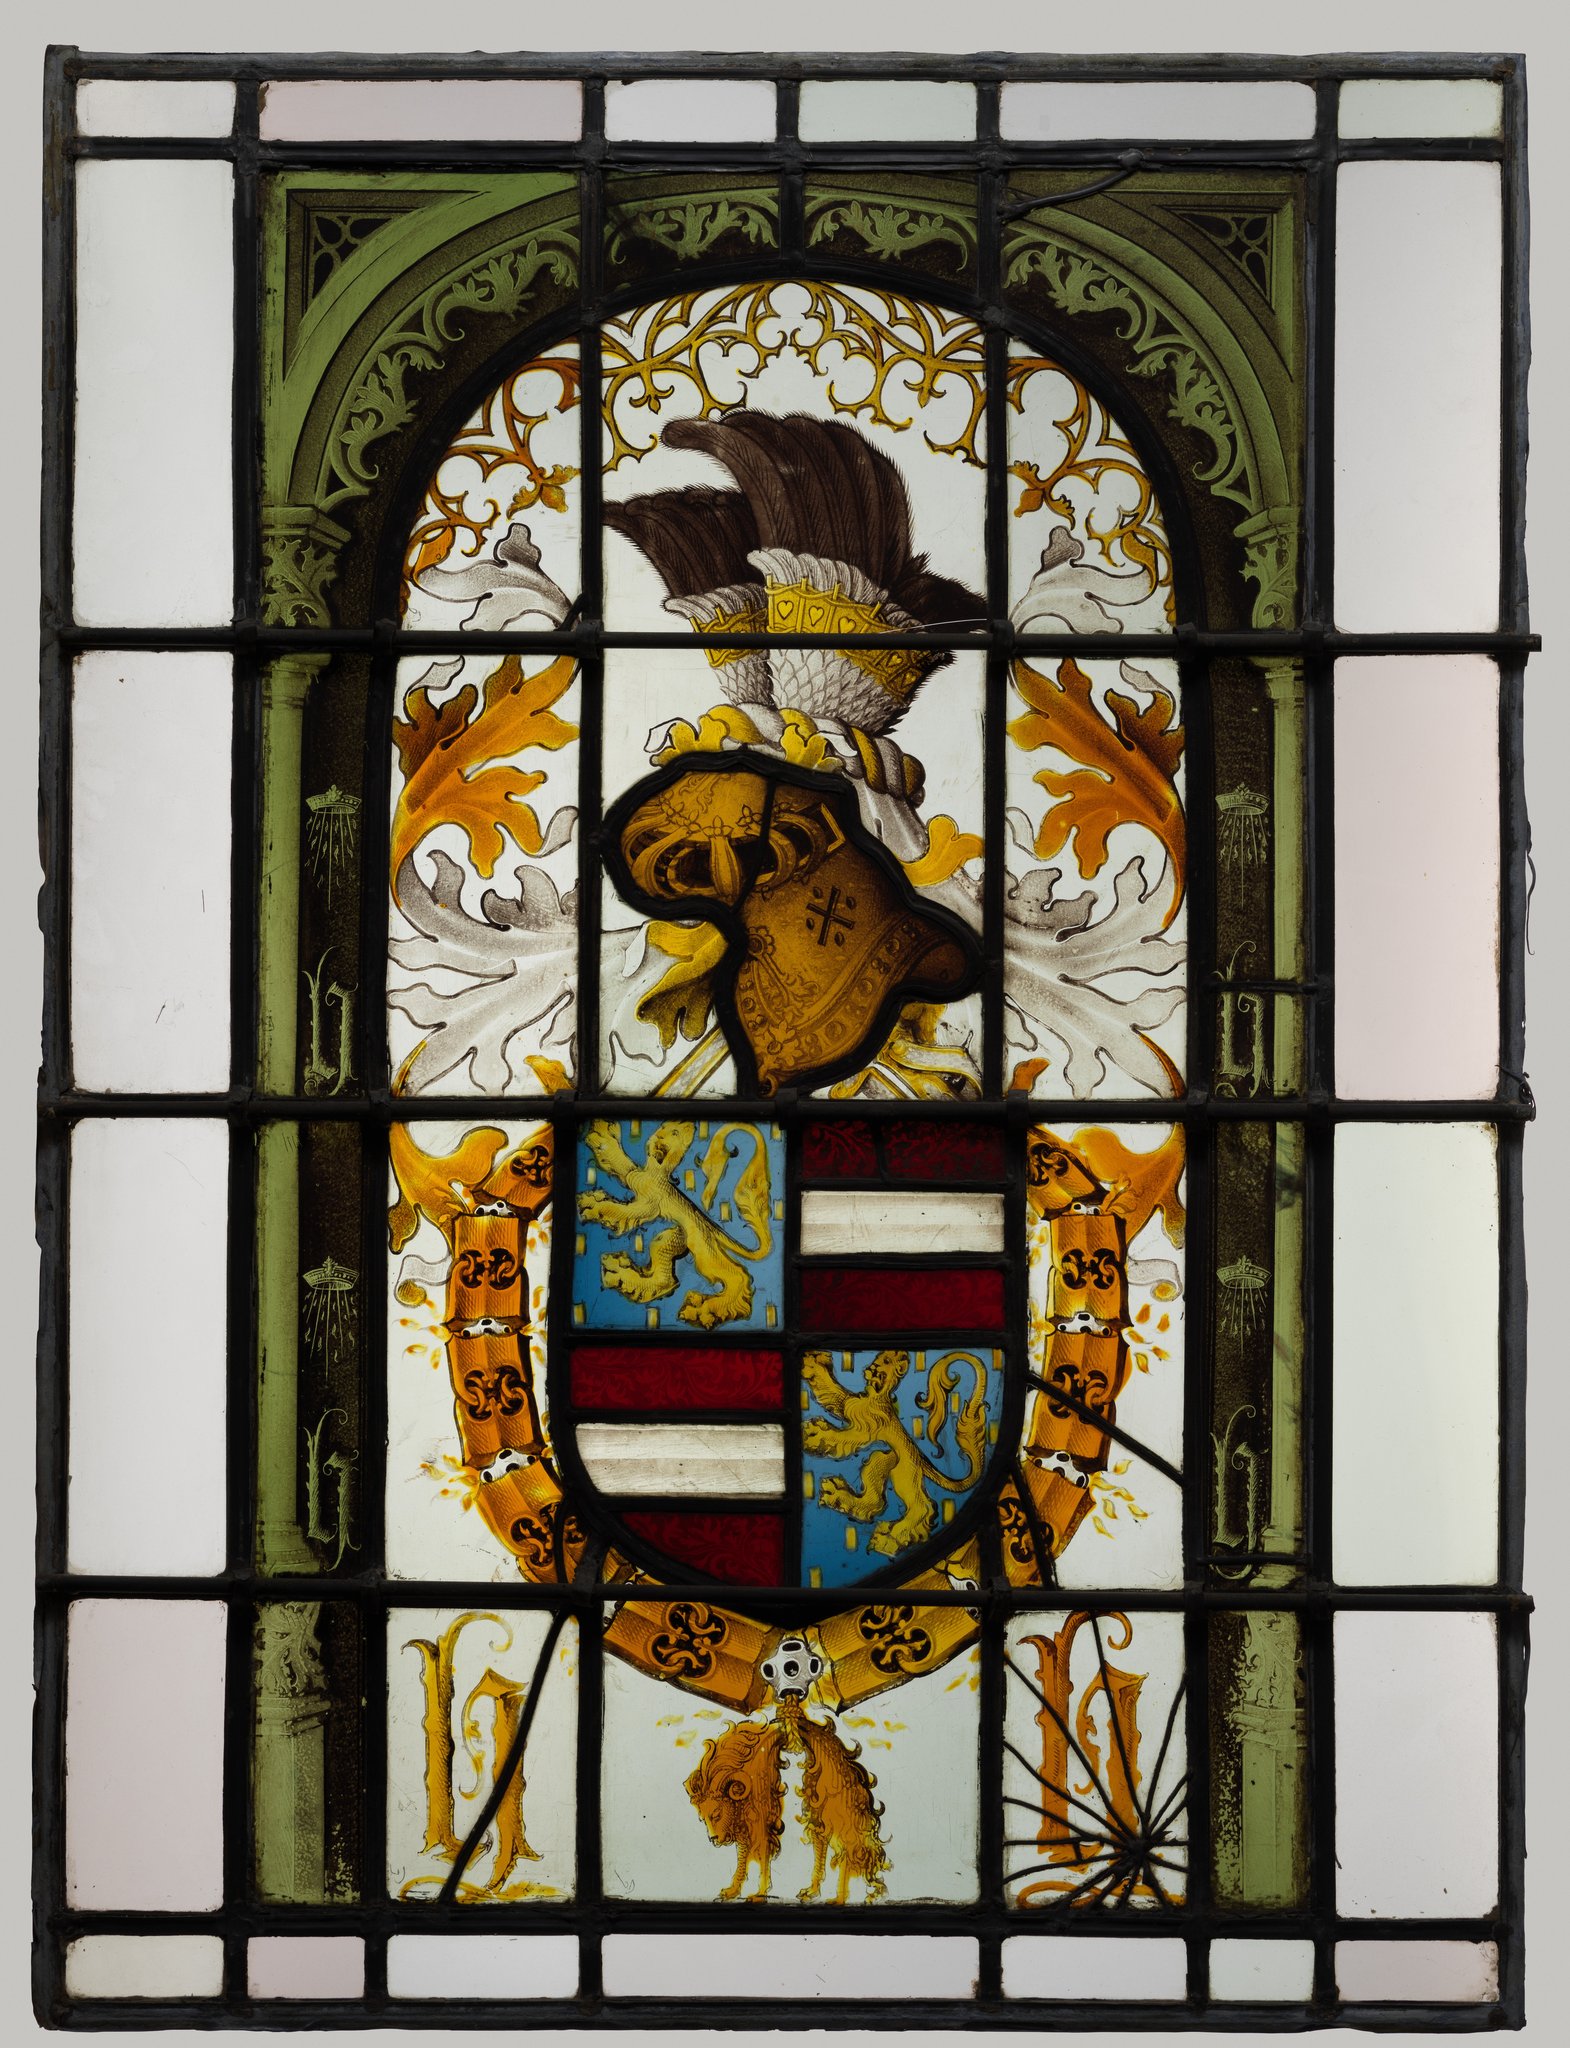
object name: panel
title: Heraldic Panel with Arms of the House of Hapsburg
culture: south netherlandish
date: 1504-1506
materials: glass, metal, paint, pigment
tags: coat of arms